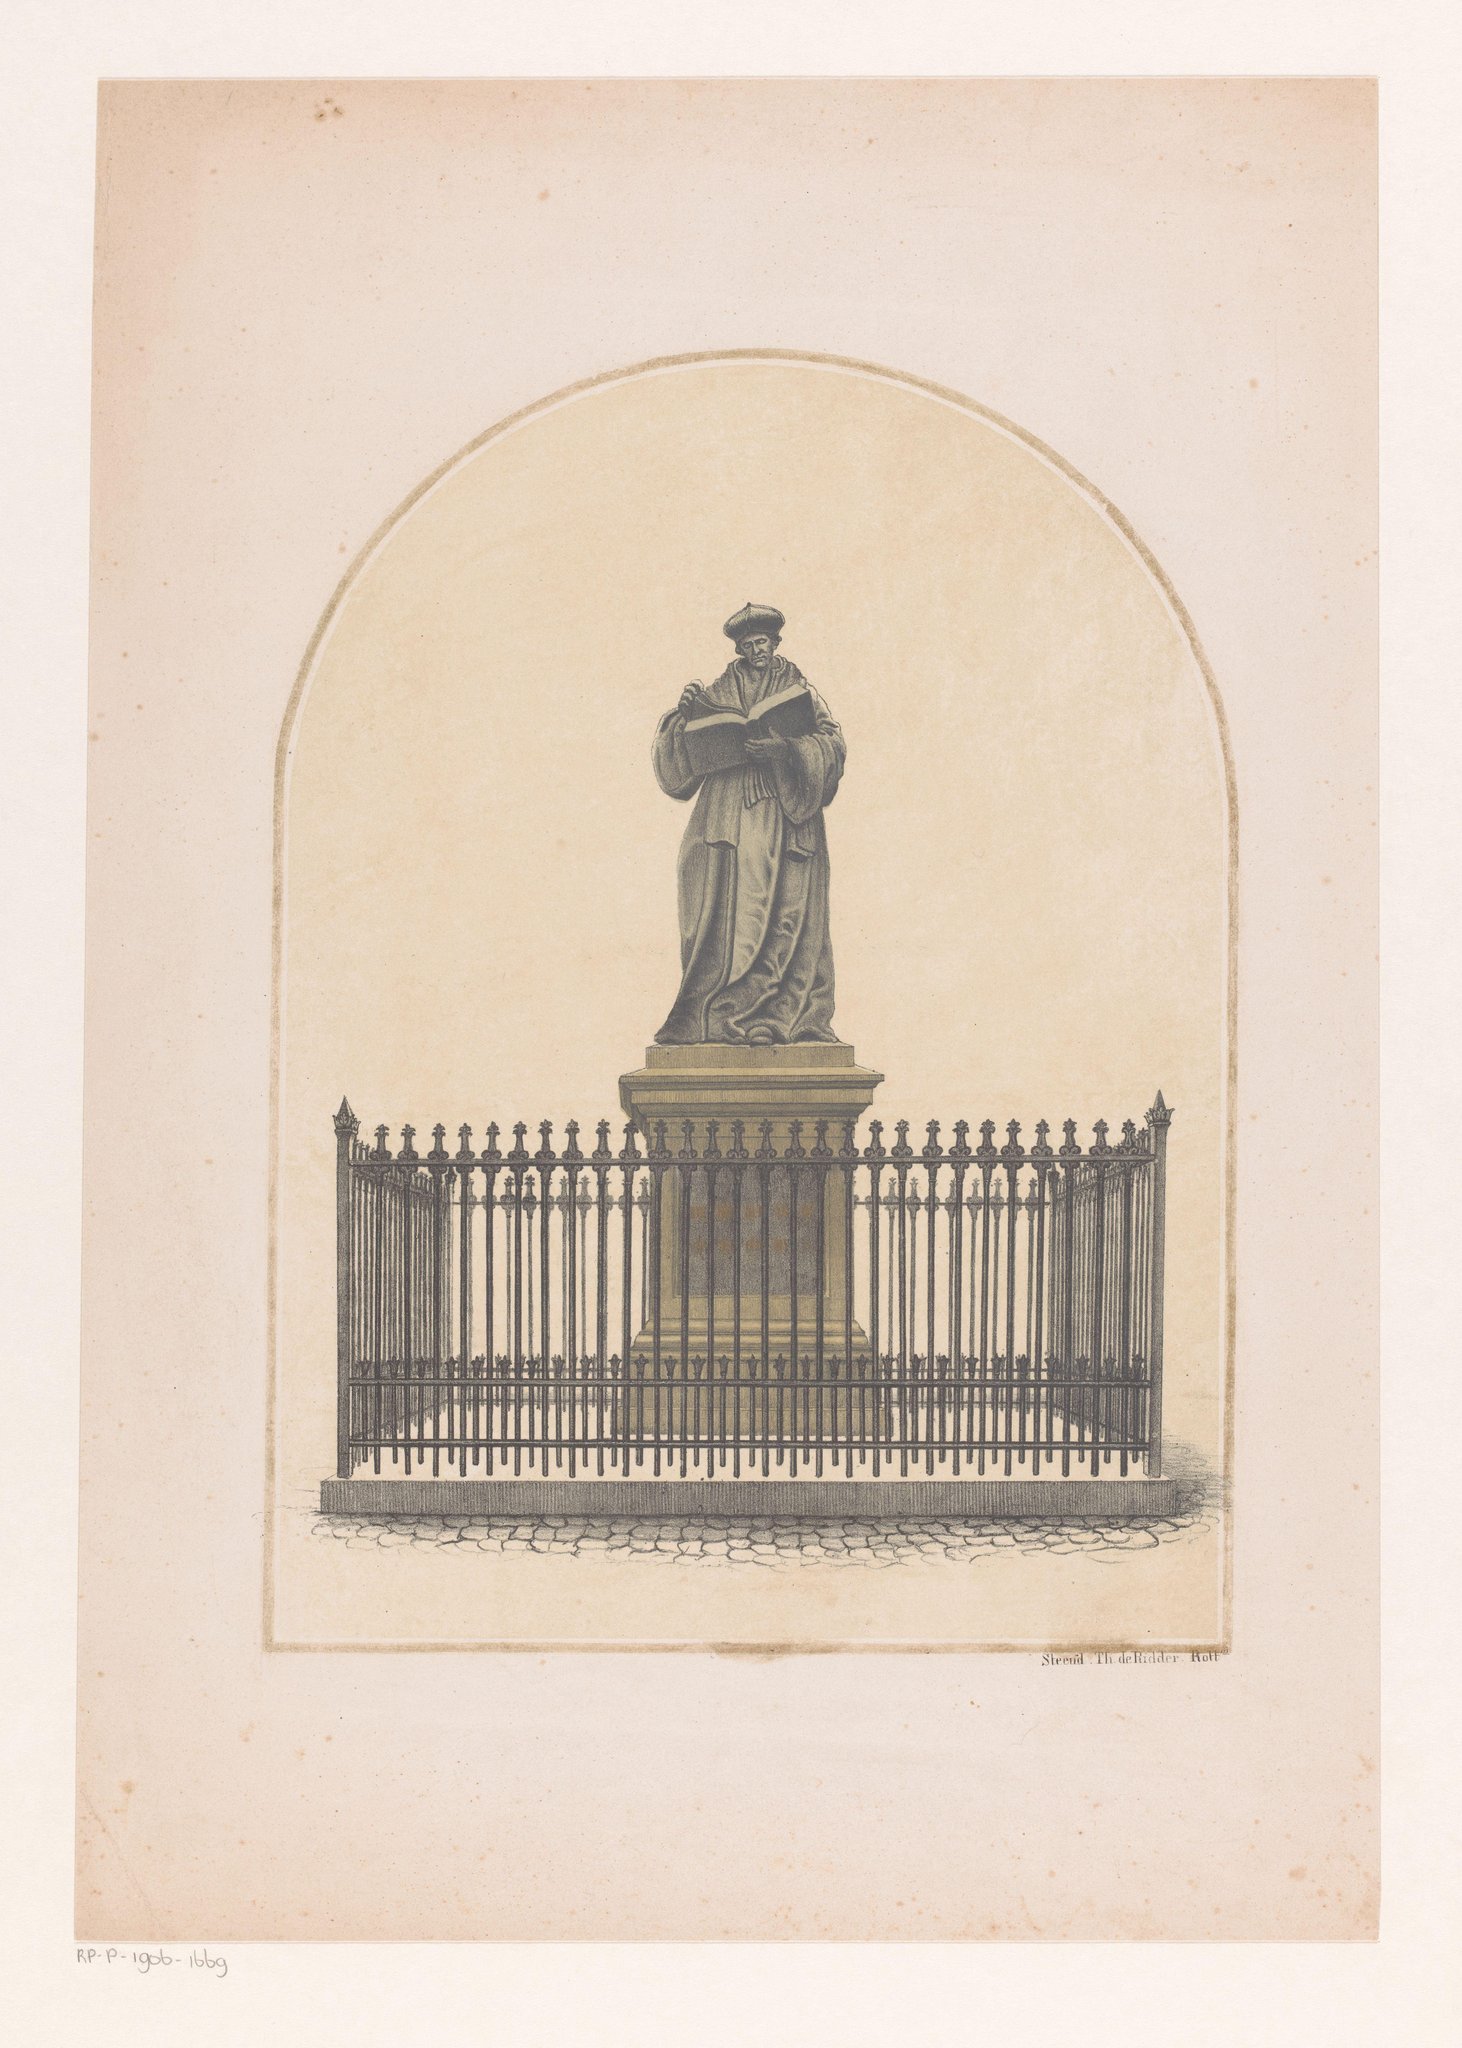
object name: print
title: Erasmusbeeld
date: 1833-1892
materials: paper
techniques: tone lithography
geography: rotterdam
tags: desiderius erasmus, monument, statue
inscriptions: collector's mark: Lugt 2228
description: Het standbeeld van Desiderius Erasmus lezend in een open boek te Rotterdam, omgeven door een hek.